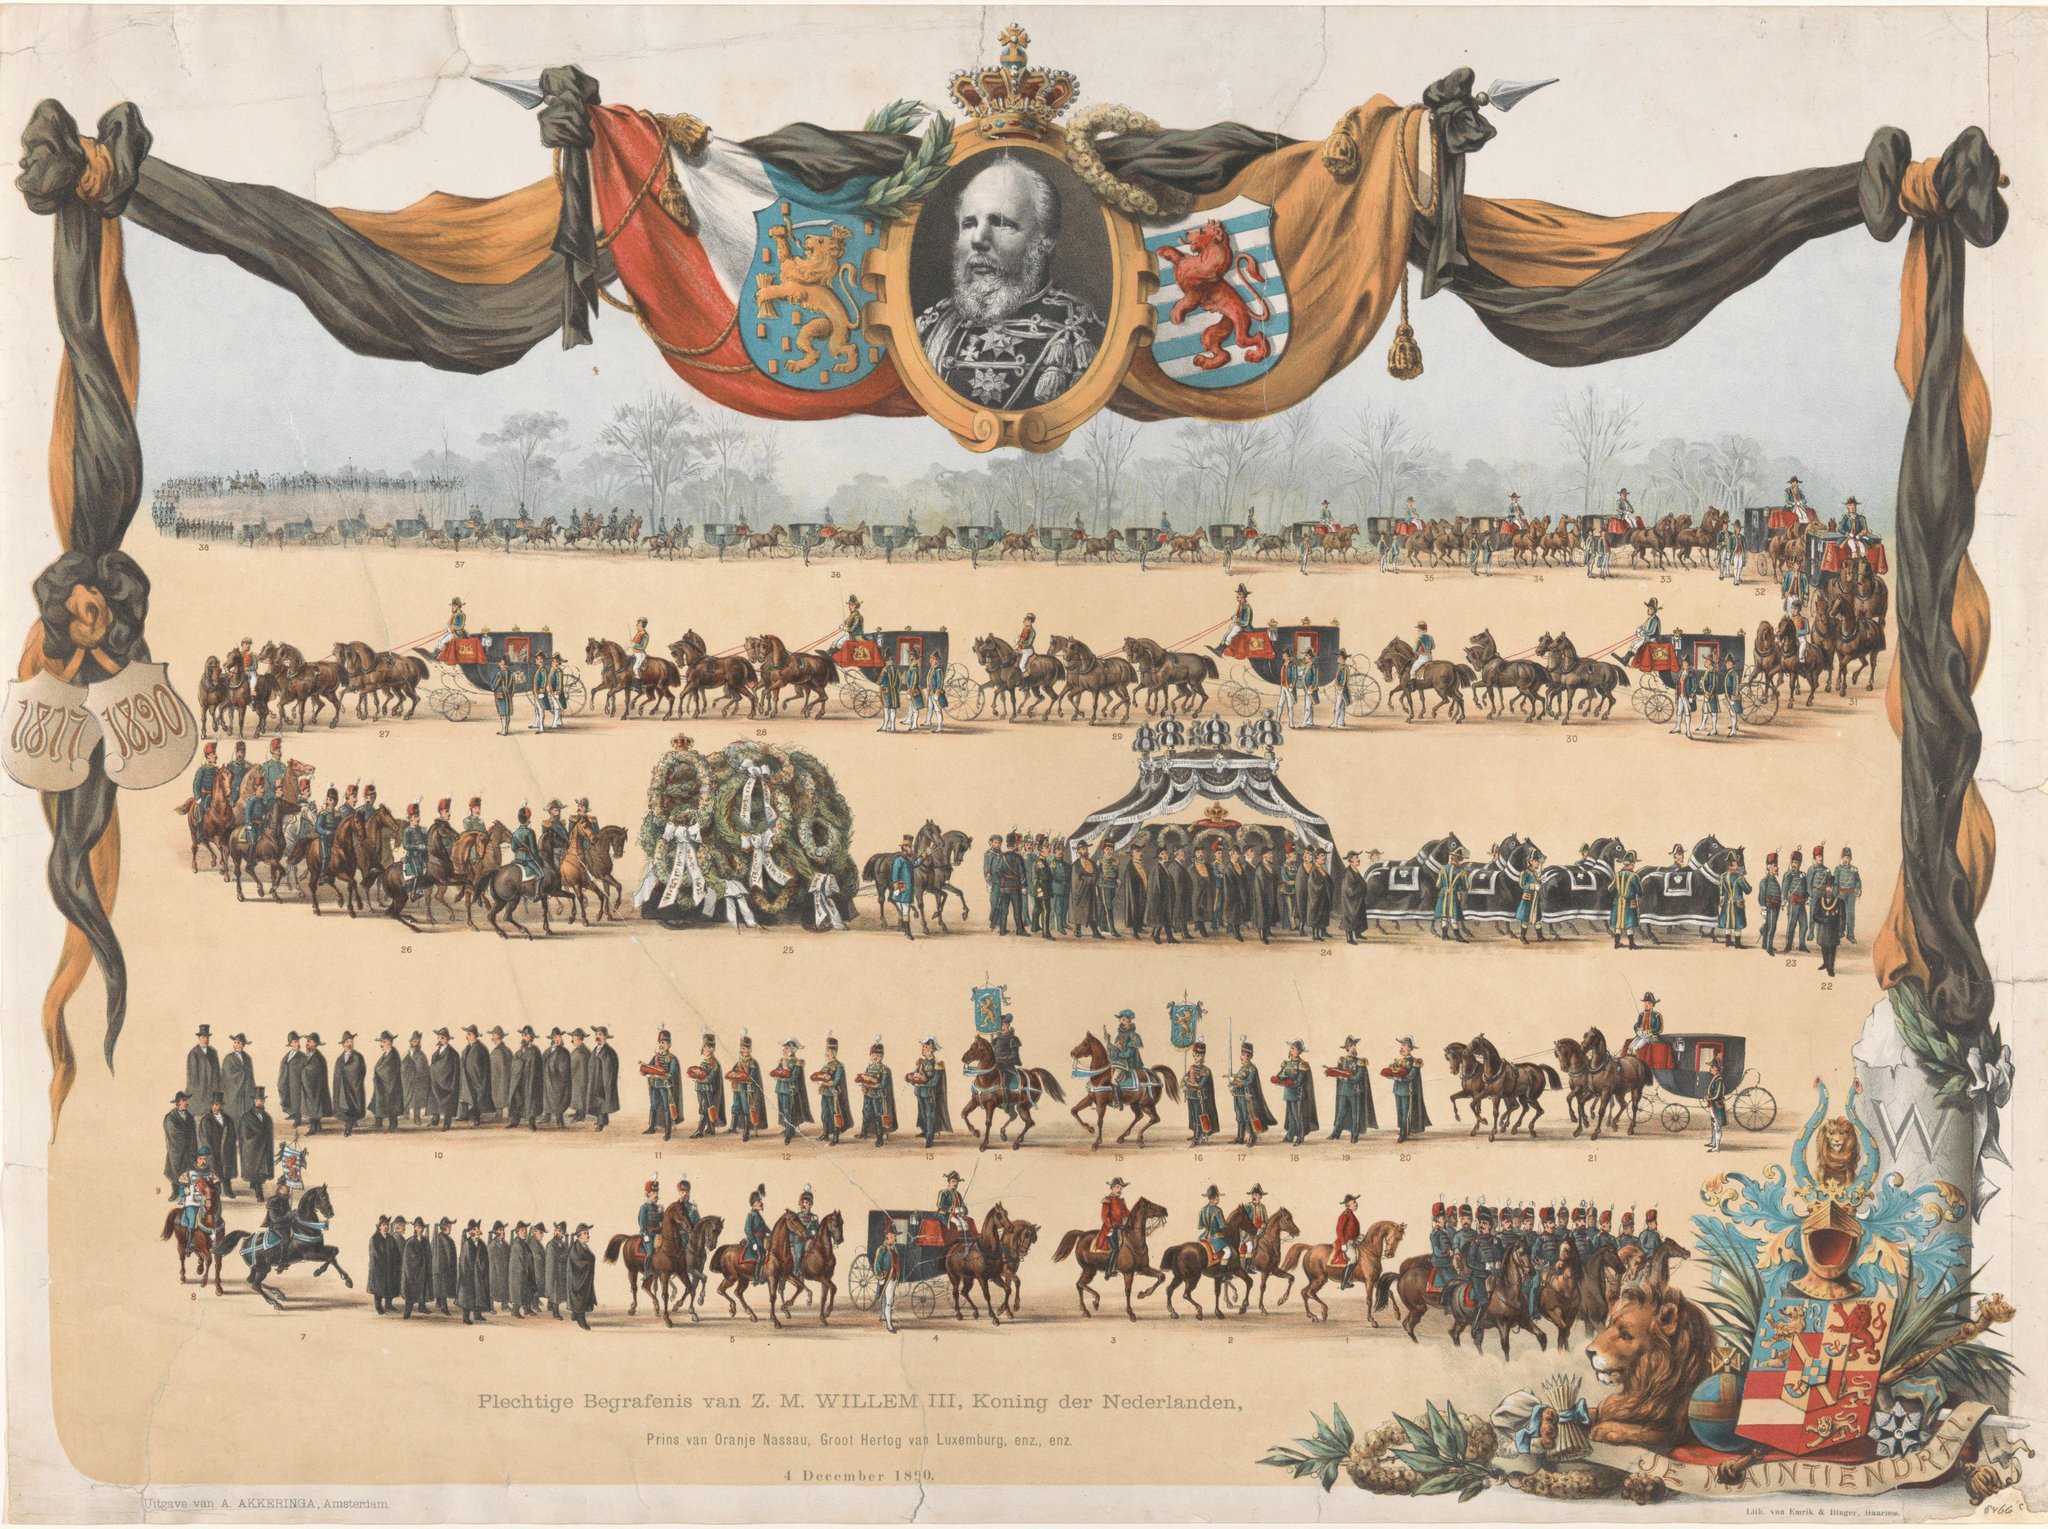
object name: print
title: Plechtige Begrafenis van Z.M. Willem III, Koning der Nederlanden (...) 4 December 1890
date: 1890-1891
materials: paper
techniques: lithograph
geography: amsterdam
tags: brussels, willem iii (koning der nederlanden), cortege, funeral procession, delft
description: Begrafenis van Koning Willem III op 4 december 1890 te Delft. De stoet afgebeeld in vijf rijen onder elkaar binnen een omlijsting van oranjedoeken en rouwdoeken. Linksonder de Nederlandse Leeuw bij het familiewapen van de koning. Bovenaan een portret van de overleden koning.